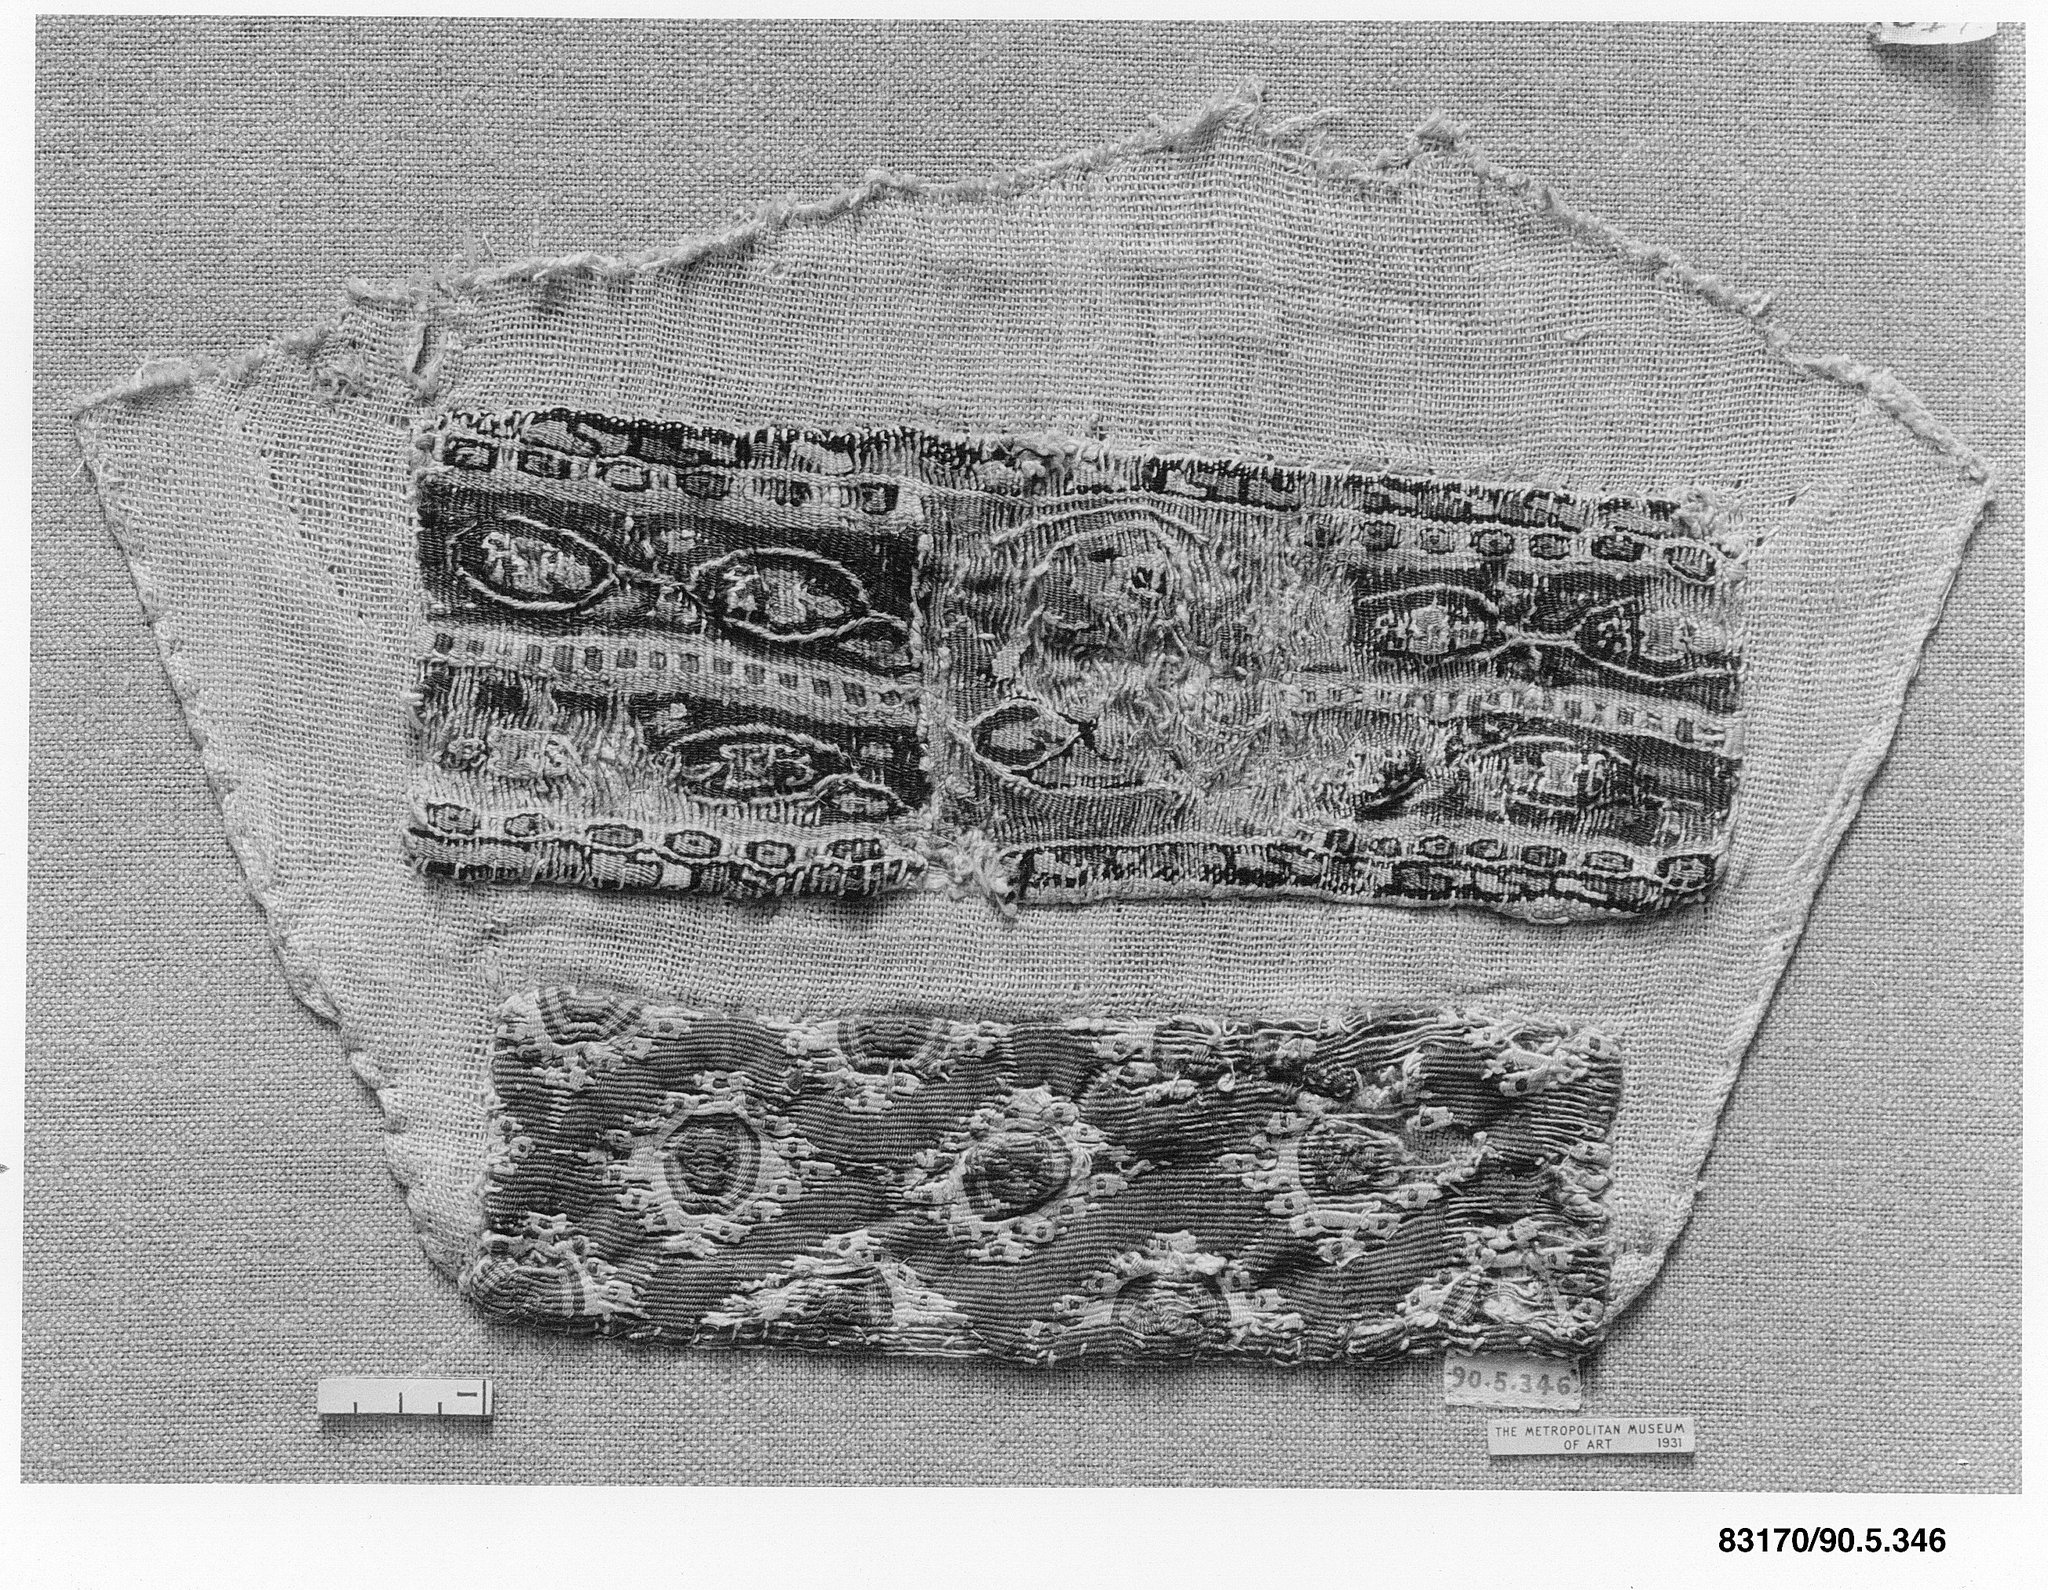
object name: textile fragment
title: Fragment of a Sleeve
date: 501-600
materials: linen, wool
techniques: weave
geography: egypt